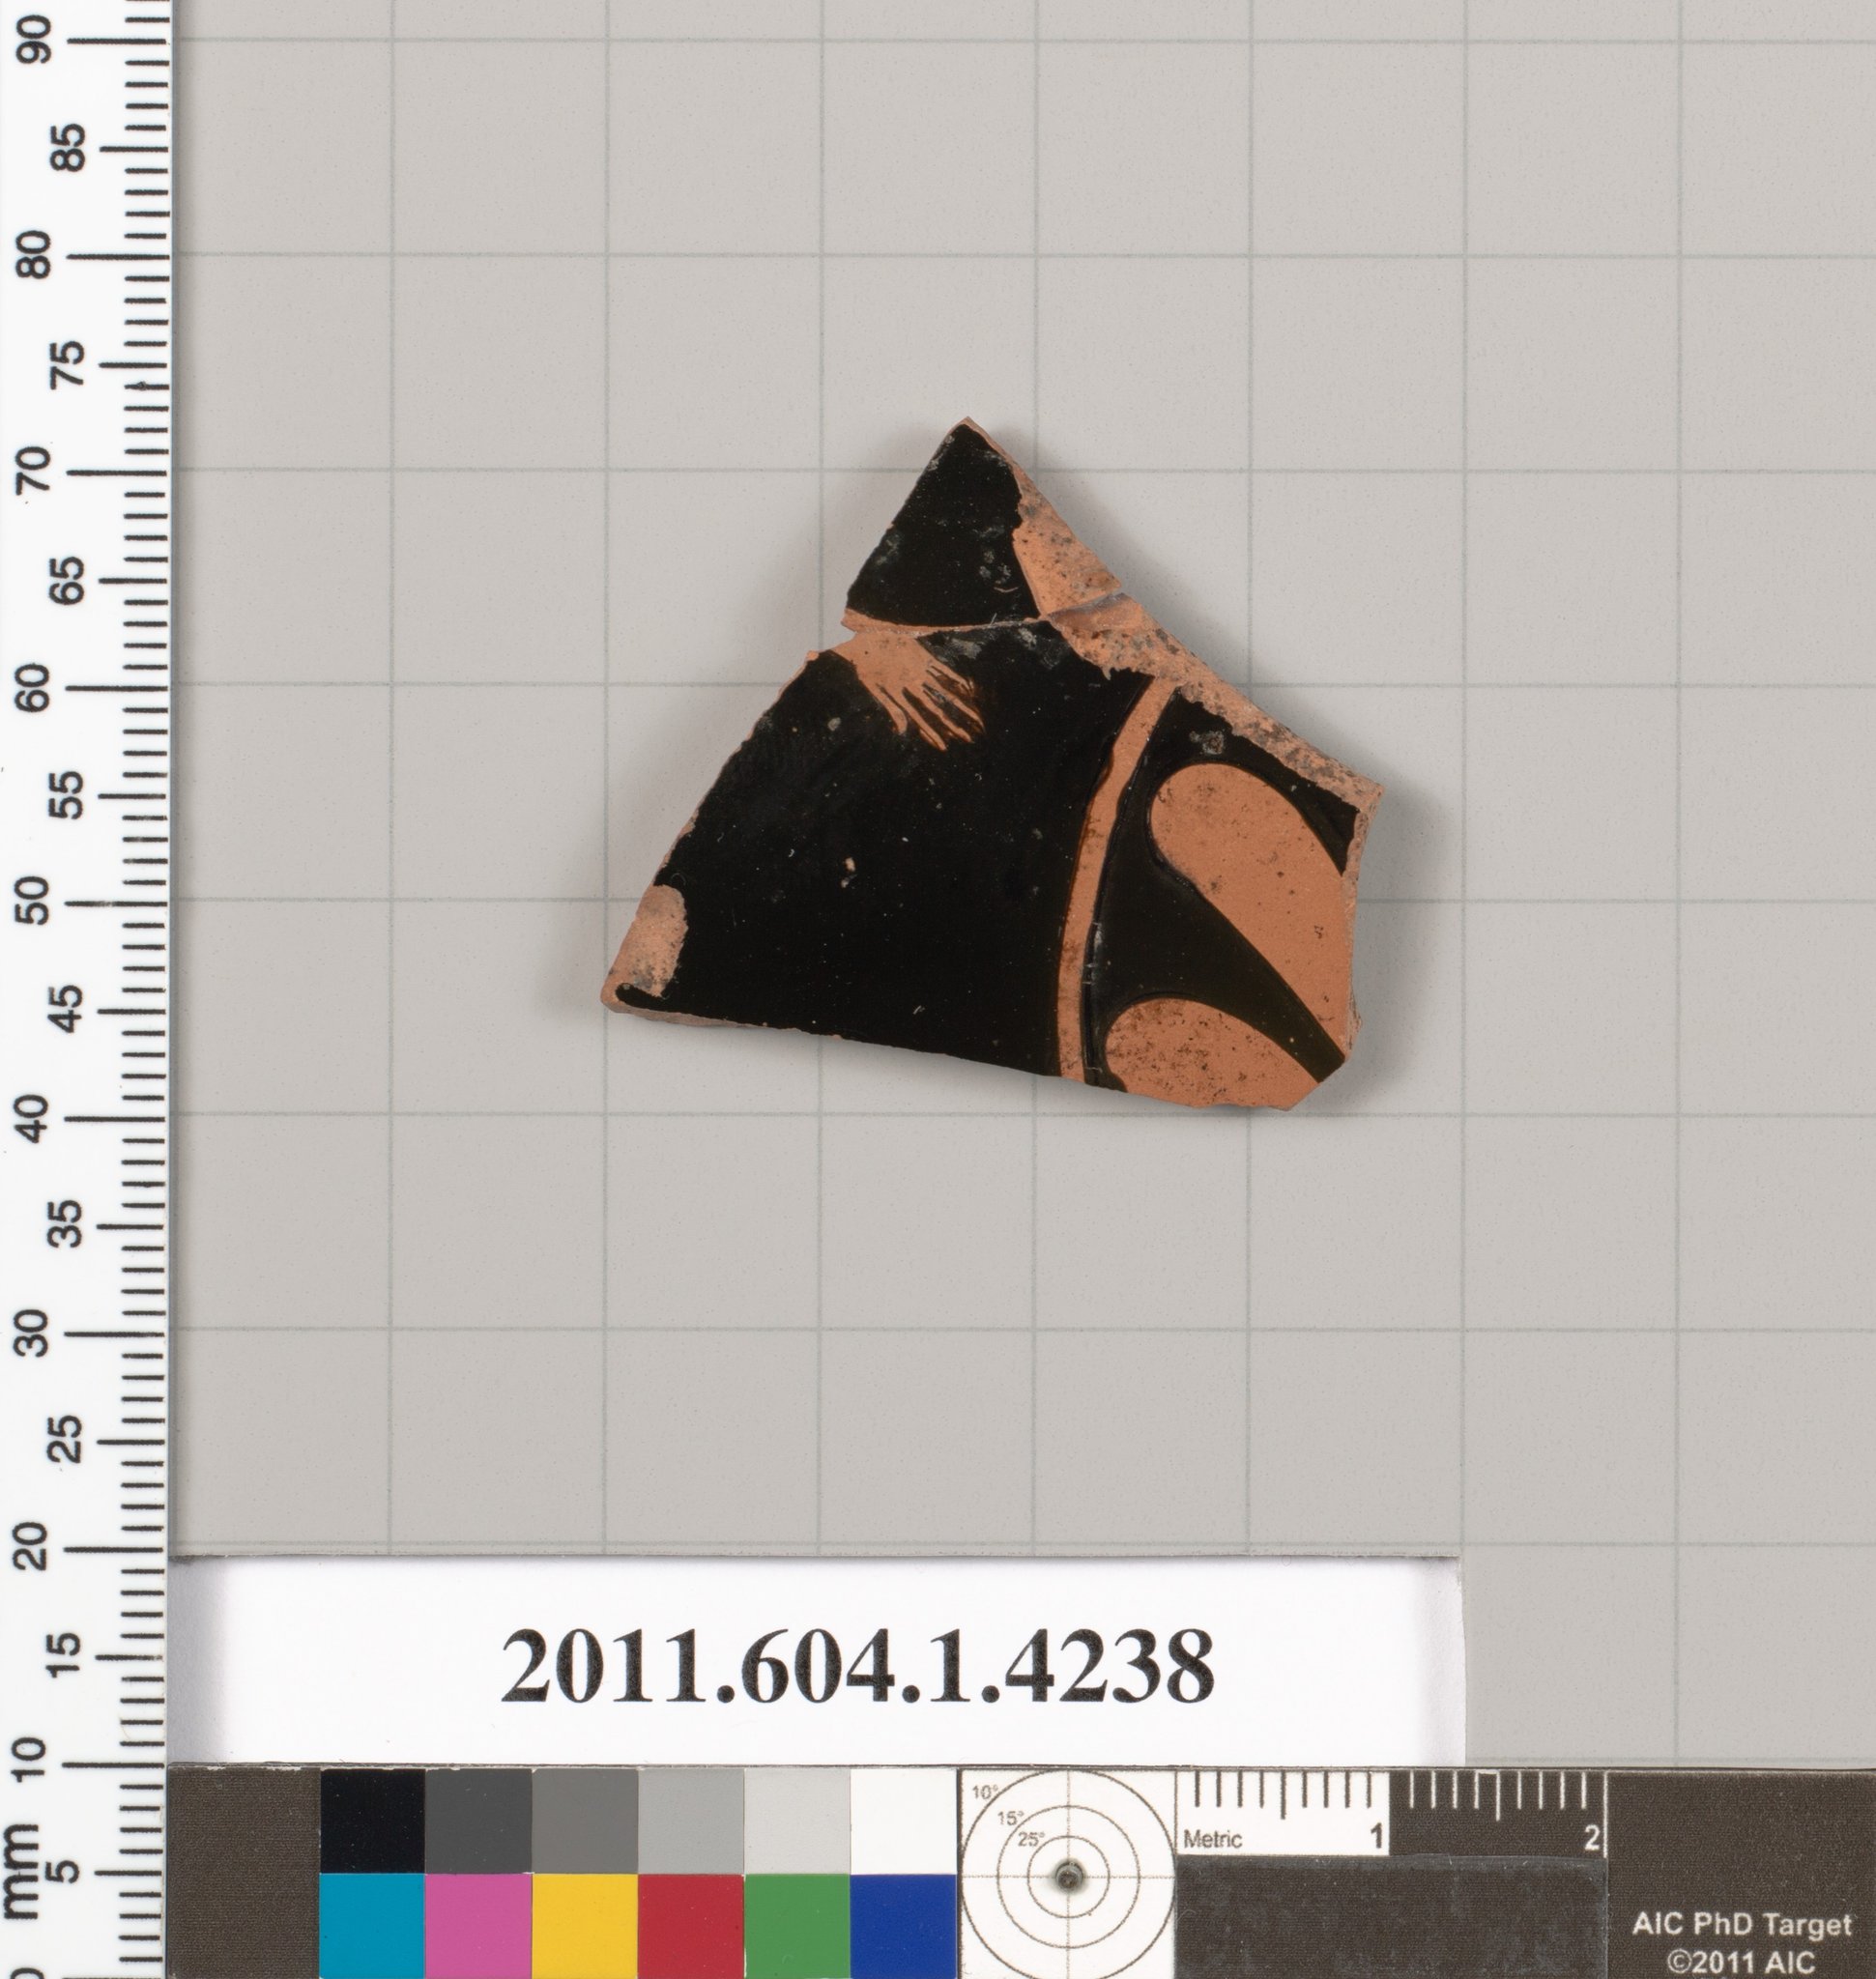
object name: kylix fragment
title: Terracotta fragment of a kylix (drinking cup)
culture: greek, attic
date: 520-490 BCE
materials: terracotta